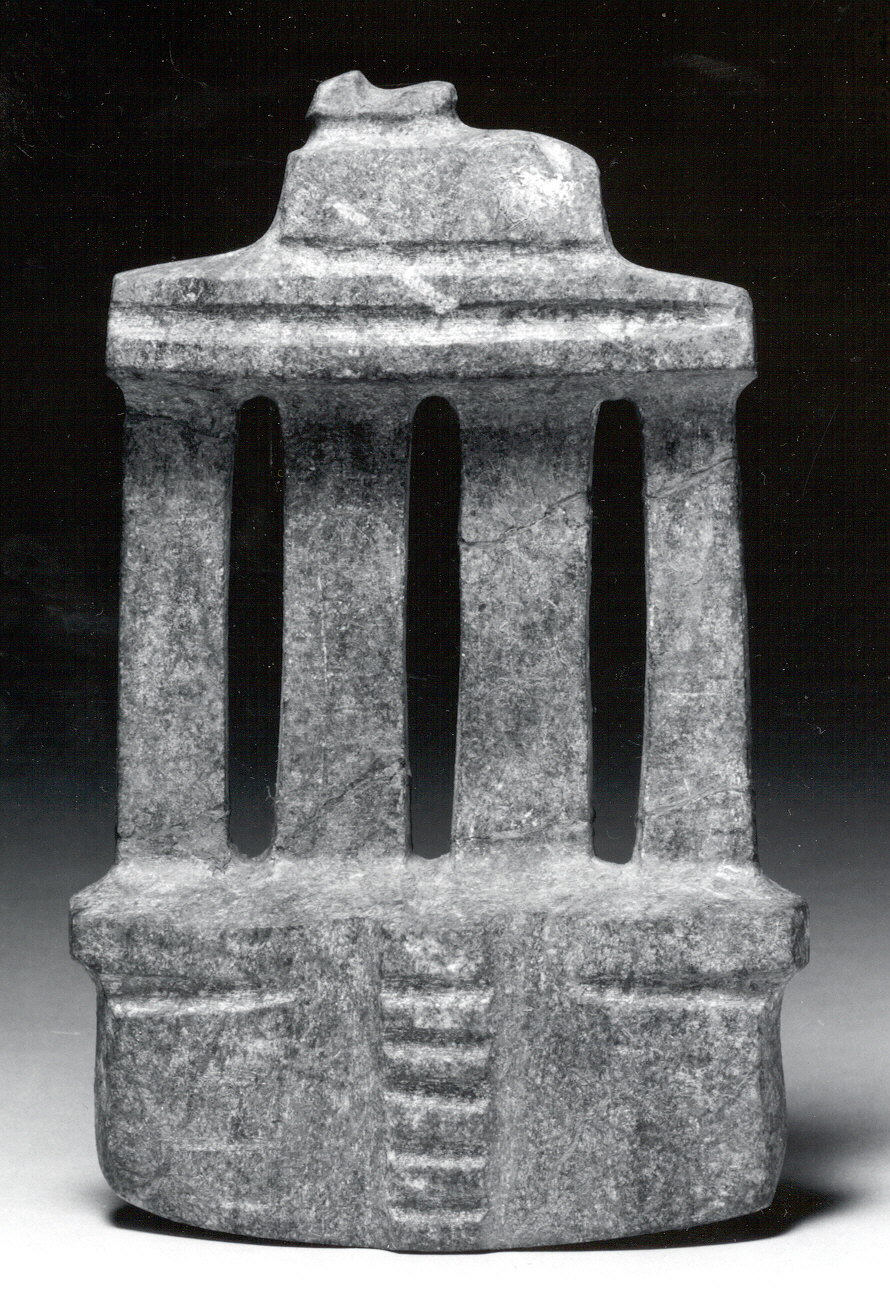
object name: architectural model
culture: mezcala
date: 1-800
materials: stone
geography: mexico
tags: temples